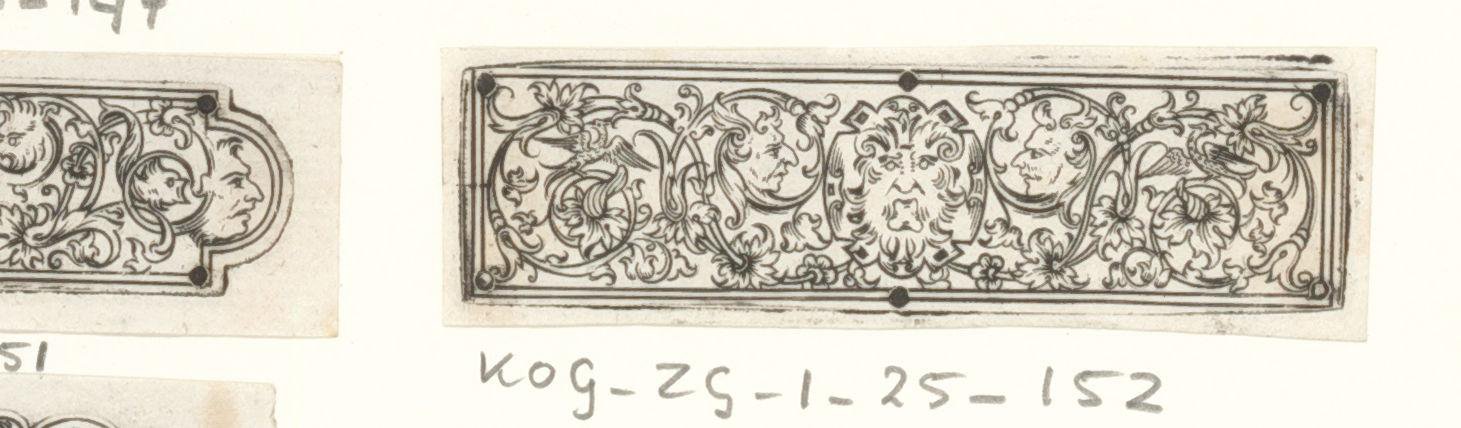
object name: print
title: Drie gezichten in ornamentele omlijsting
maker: Anonymous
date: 1600-1699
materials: paper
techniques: engraving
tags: face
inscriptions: collector's mark: Lugt 963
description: Onderwerpsrubrieken binnen de Atlas Zeden en Gewoonten: Zeden en Gewoonten in Engeren Zin, De Woning, Huisraad, Zilverwerk.